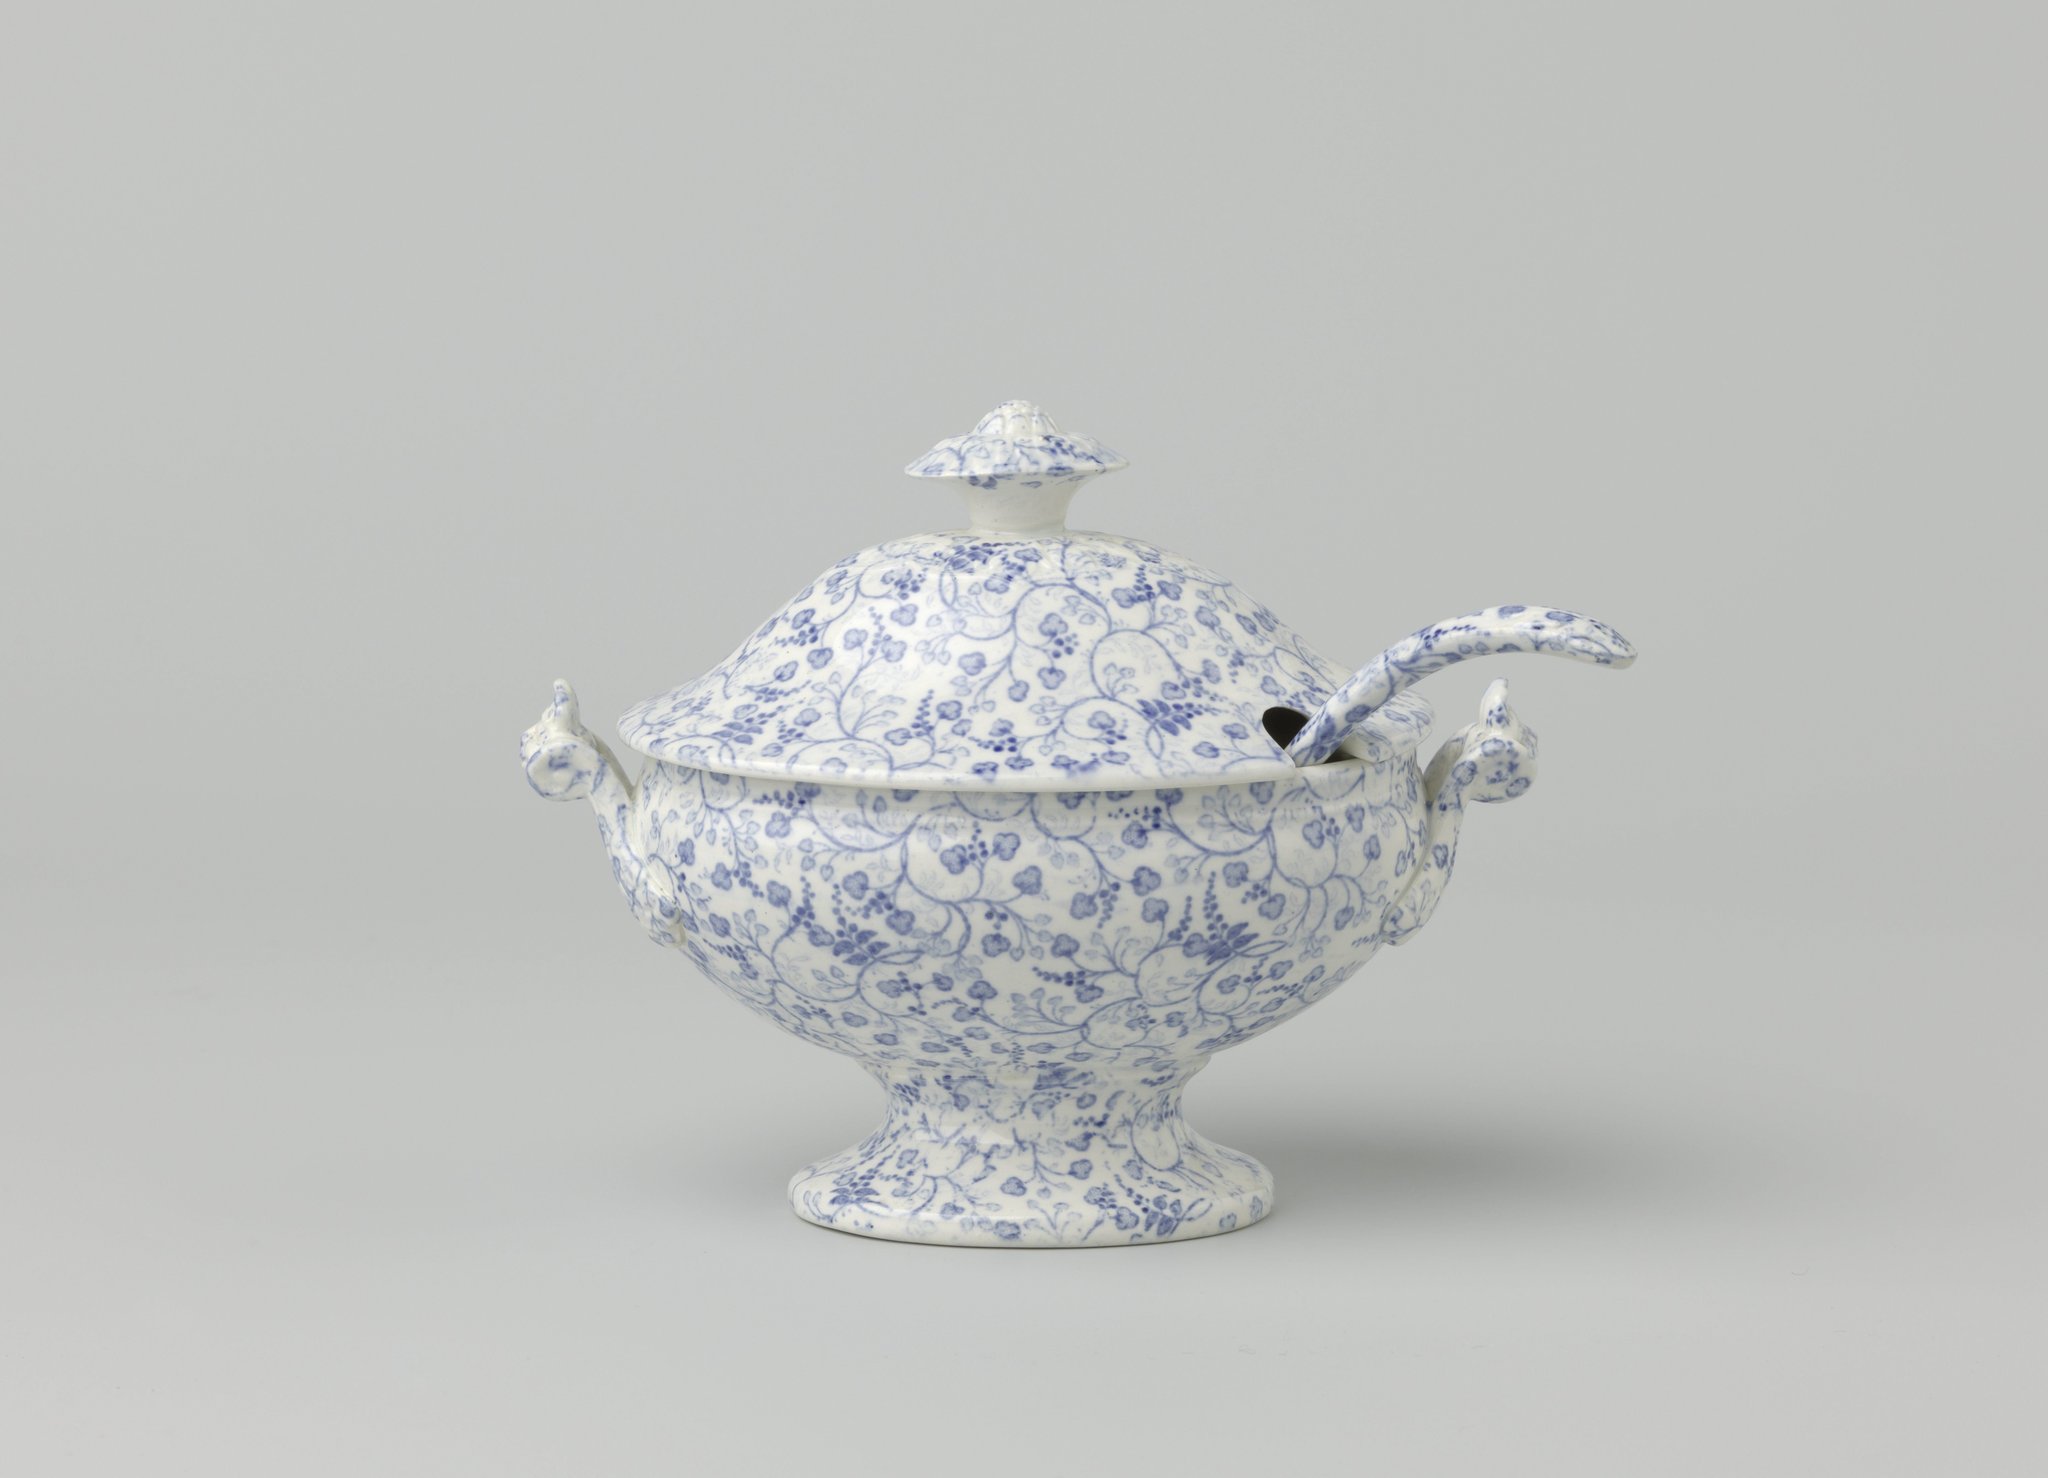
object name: soup tureen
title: Soepterrine met deksel en lepel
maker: petrus regout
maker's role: plateelbakker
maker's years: 1801-1879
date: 1867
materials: creamware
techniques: transfer decoration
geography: maastricht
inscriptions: check stamp: ‘36’, mark: ‘PARSEME No 3’, check stamp: ‘PR 36’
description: Soepterrine met deksel en lepel van aardewerk met blauw doorlopend bloemendecor, behorend tot een kinderservies. De ovale terrine op voet heeft twee oren die eindigen in maskers. Het gewelfde deksel heeft aan de bovenzijde bladwerk in reliëf en een bloemvormige dekselknop. De lepel heeft een ronde bak en een s-vormige steel die uitloopt in bladwerk in reliëf.